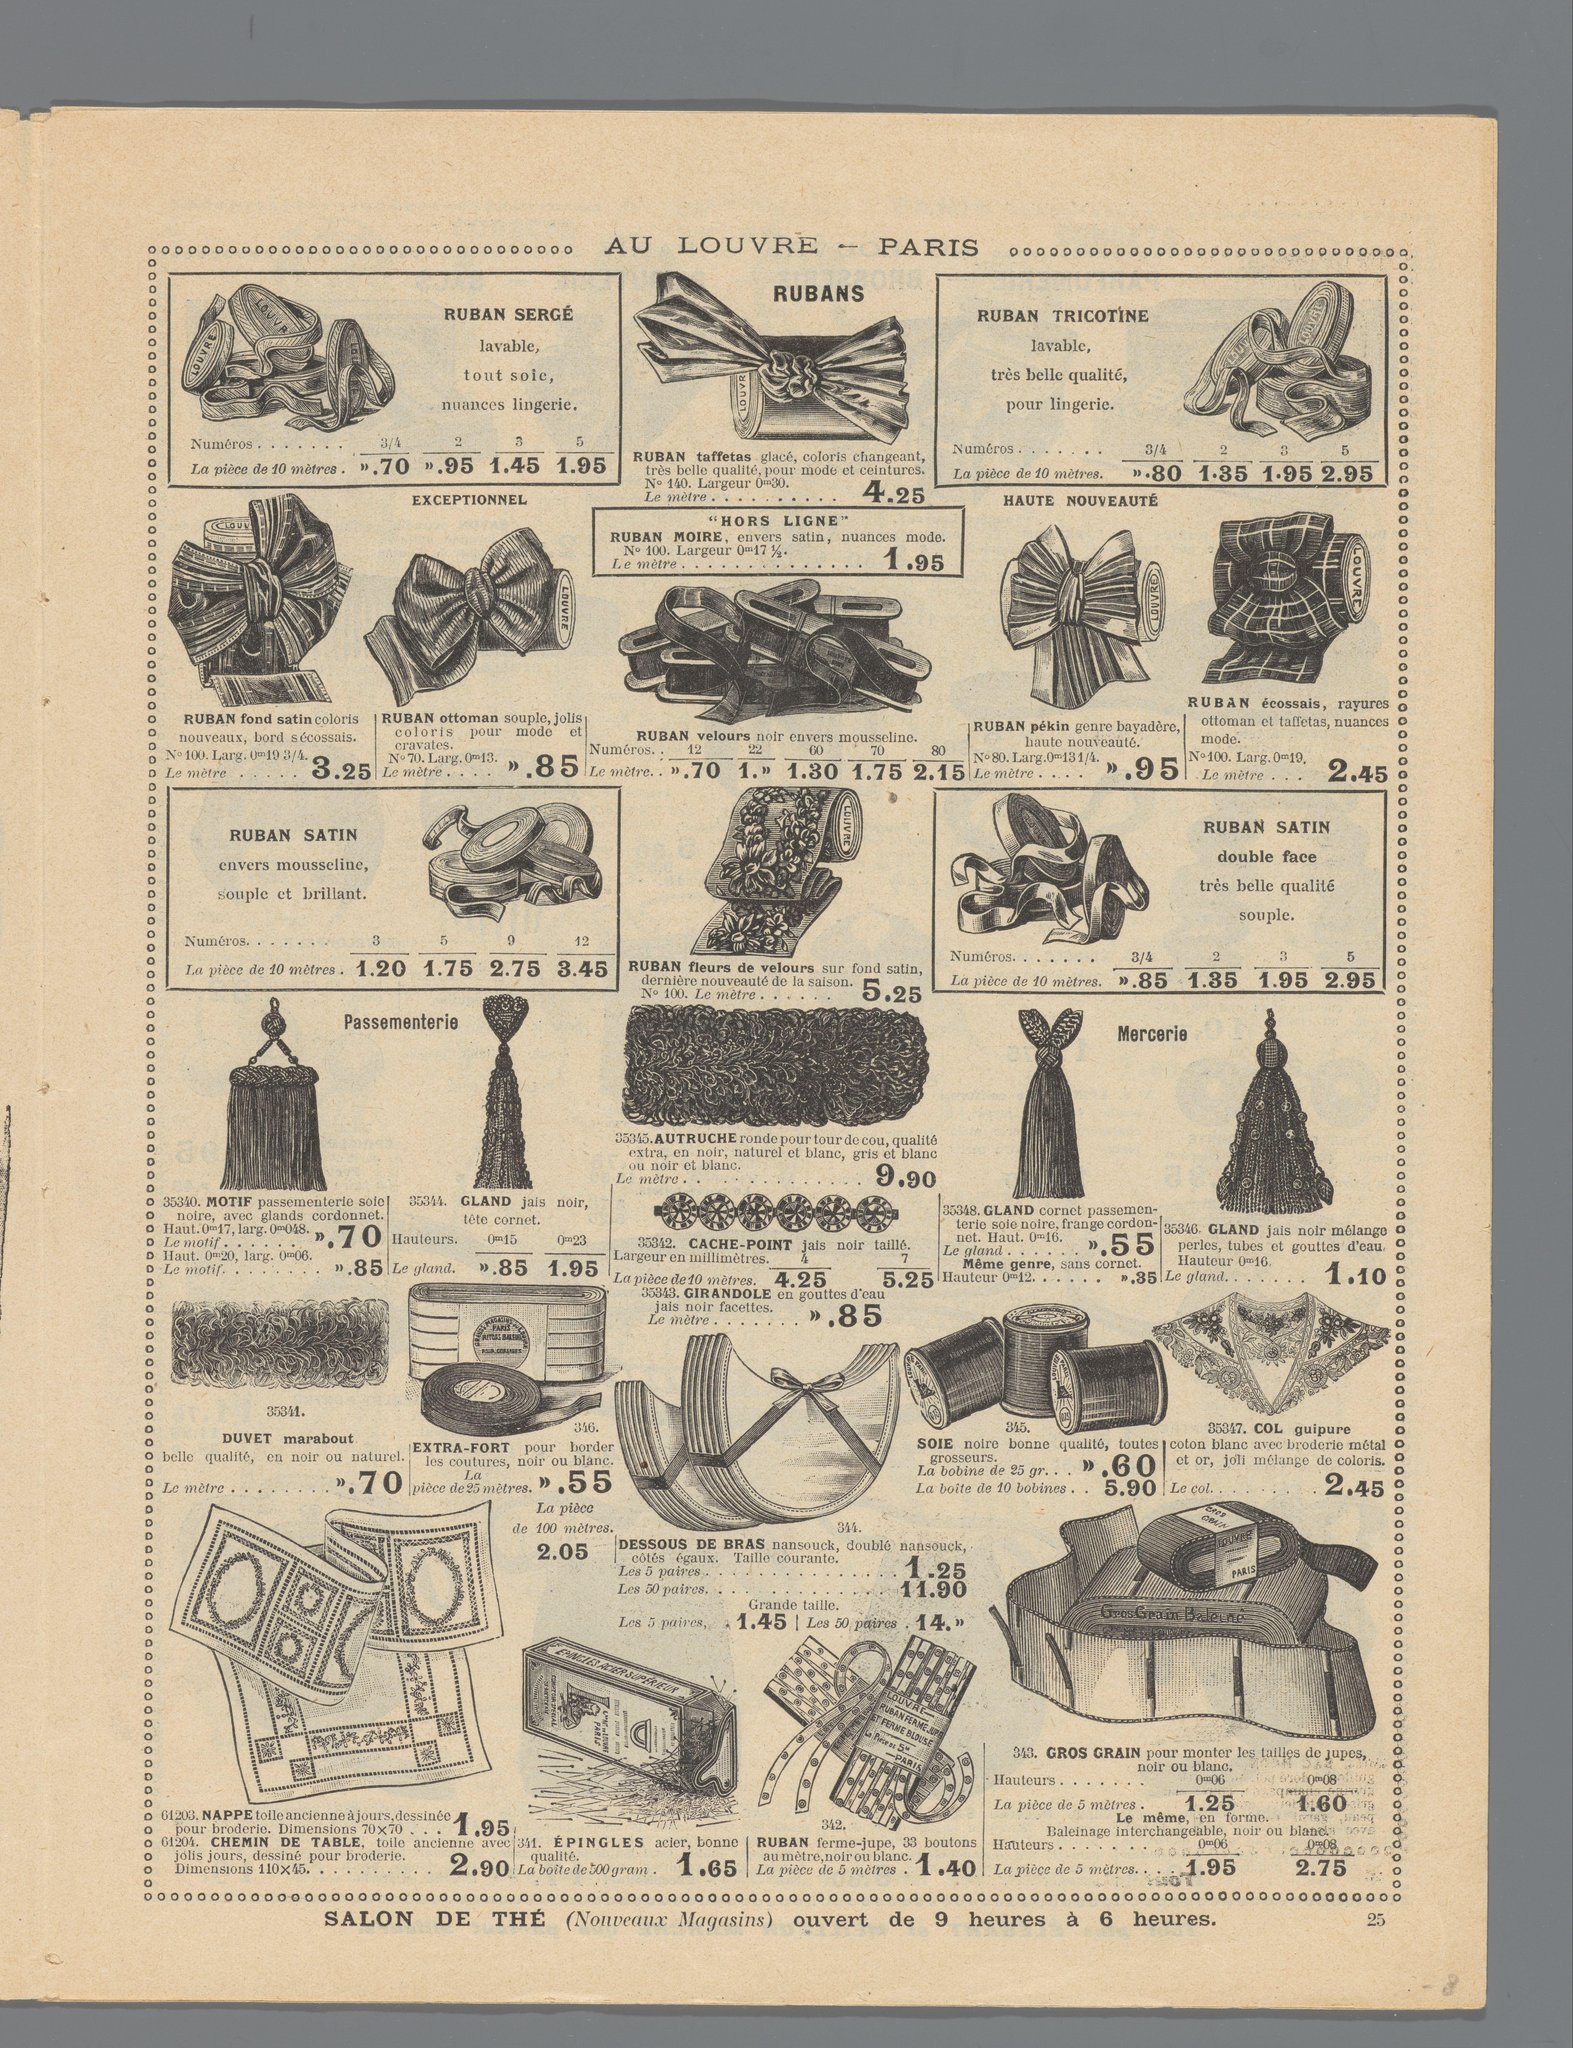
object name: print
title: Au Louvre, Paris: Lundi 2 Mars: Nouveautés d'été: pagina 25: pagina met advertenties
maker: Anonymous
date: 1913-1915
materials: paper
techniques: photography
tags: fashion plates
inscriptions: title: ‘Au Louvre, Paris: Lundi 2 Mars: Nouveautés d'été’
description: Pagina in "Au Louvre - Paris" : pagina 25: advertenties van passementen, garen en band